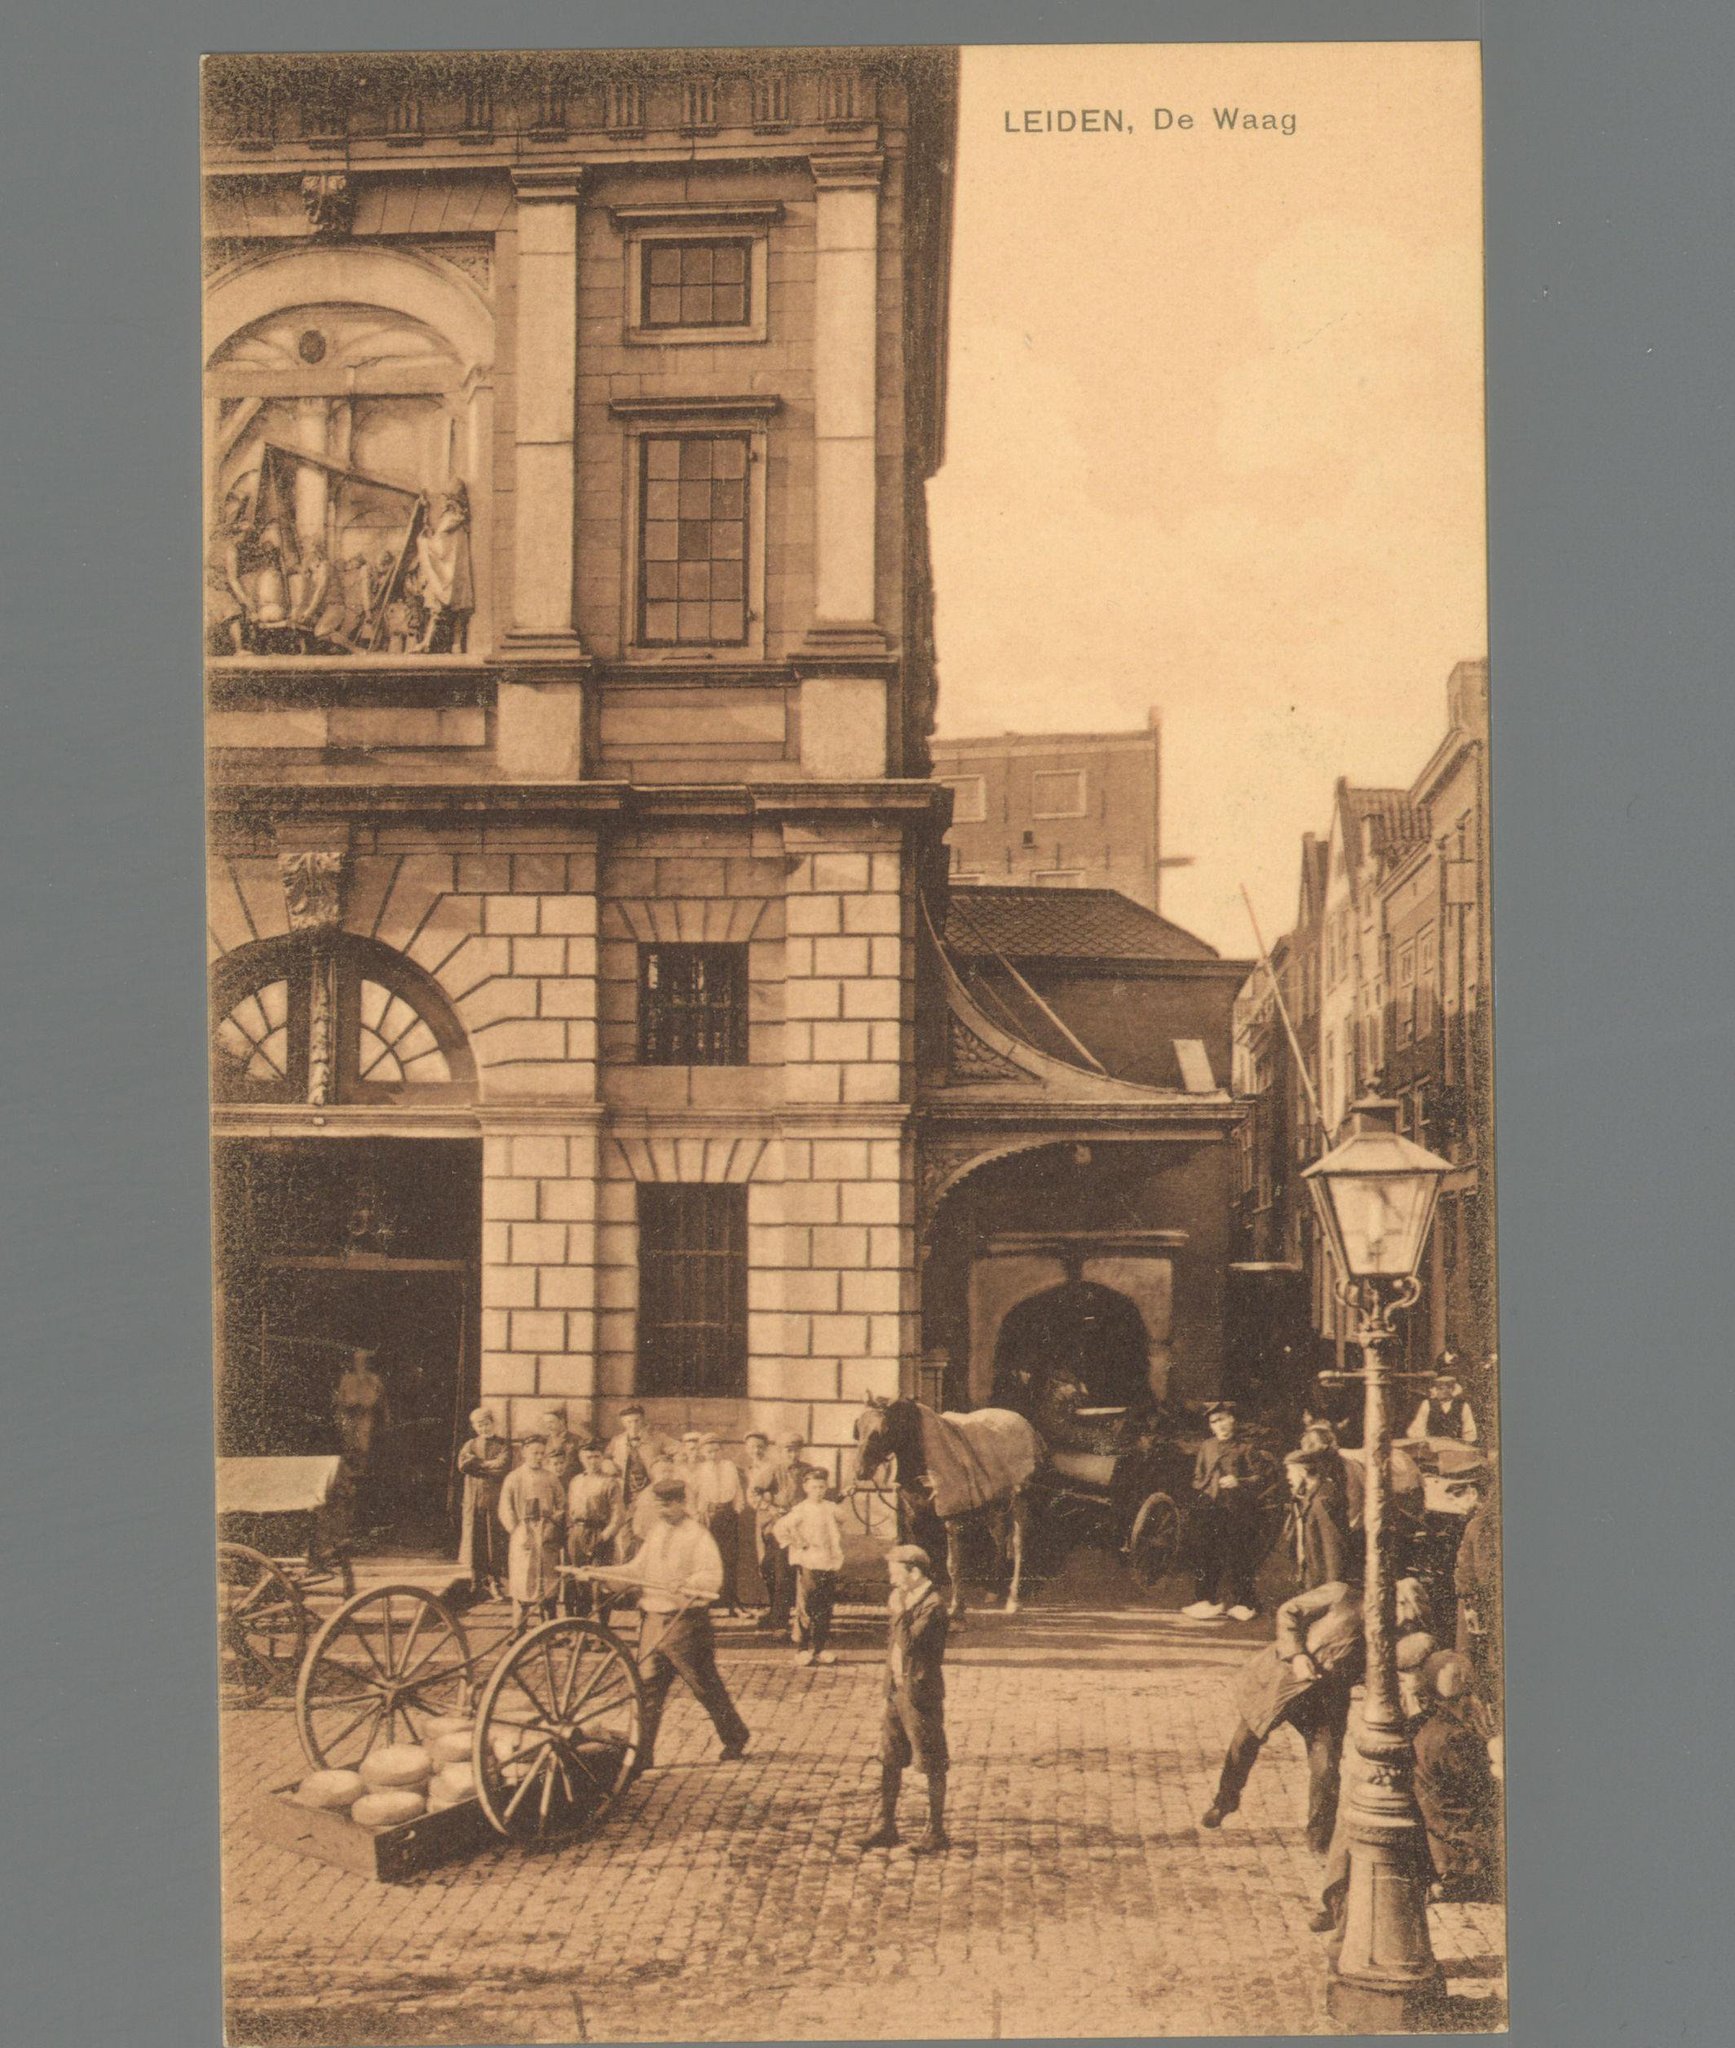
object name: ansichtkaart, prentbriefkaart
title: Leiden, De Waag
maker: Anonymous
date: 1905-1930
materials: cardboard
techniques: photograph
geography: leiden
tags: weigh-house